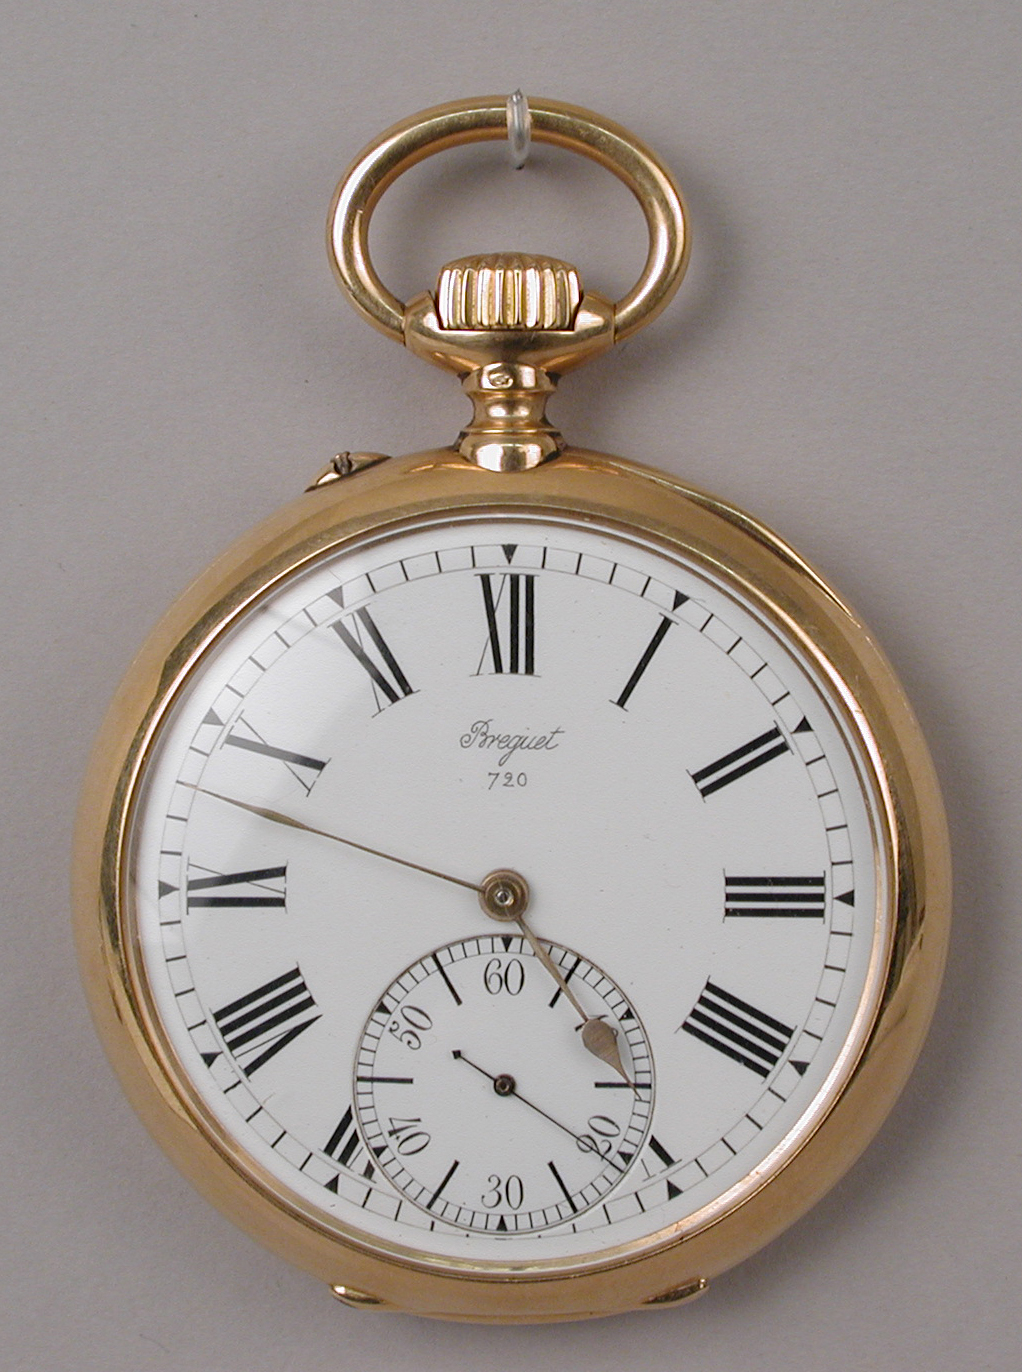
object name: pocket watch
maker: firm of breguet et fils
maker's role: maker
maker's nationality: french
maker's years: 1816-2002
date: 1900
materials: enamel, gilt brass, gold, steel